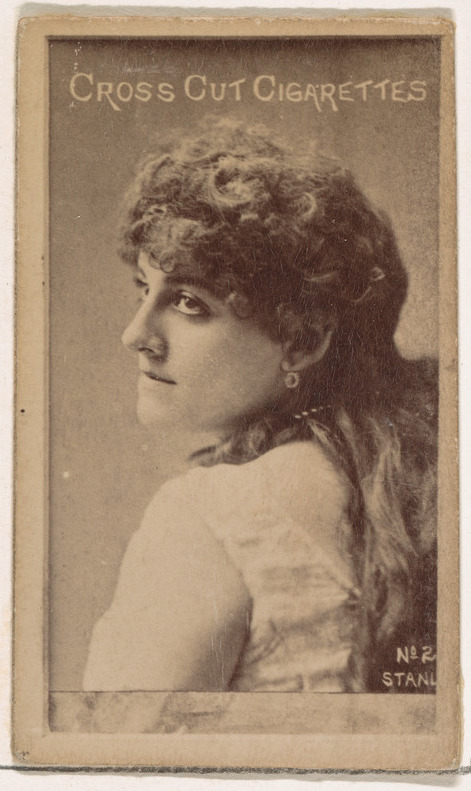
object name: print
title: Alma Stanley, from the Actors and Actresses series (N145-1) issued by Duke Sons & Co. to promote Cross Cut Cigarettes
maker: w. duke, sons & co.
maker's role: publisher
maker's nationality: american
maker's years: 1870-1920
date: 1880-1889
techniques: albumen silver print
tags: women,actresses